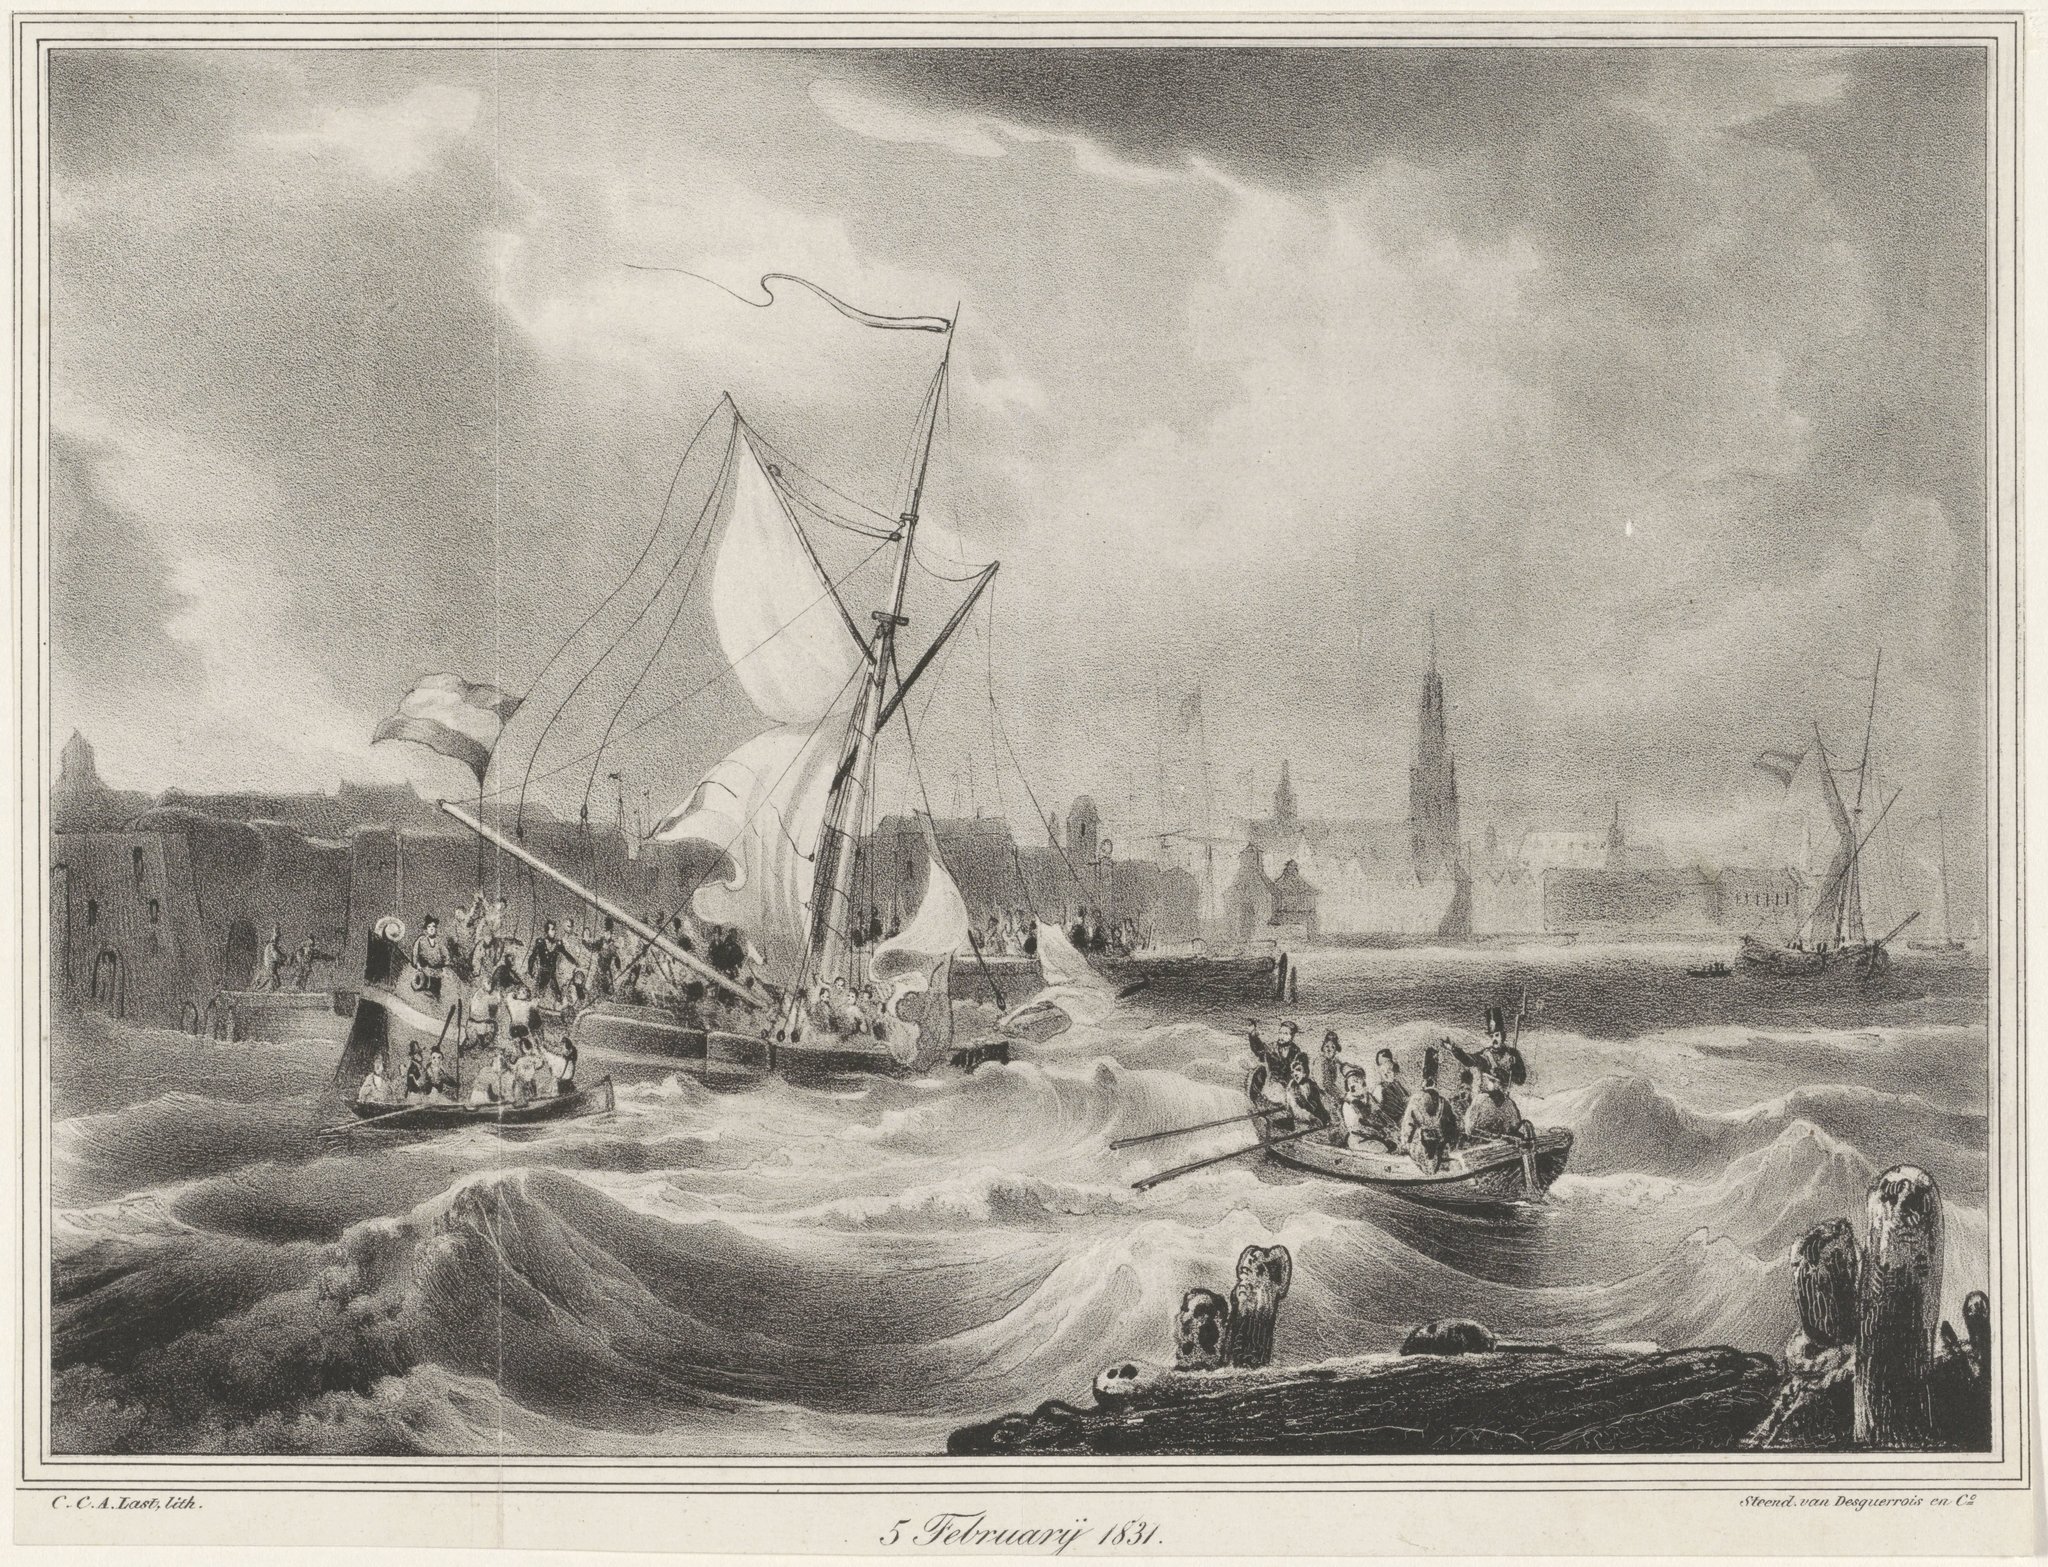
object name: print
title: Overrompelen van de boot van Jan van Speyk, 1831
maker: carel christiaan antony last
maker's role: print maker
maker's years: 1808-1876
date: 1837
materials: paper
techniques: lithograph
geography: netherlands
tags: amsterdam, antwerp, jan van speyk, navy (+ sailing-ships)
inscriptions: collector's mark: Lugt 2228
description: Gebruikt als illustratie in: Nederlandsch museum : geschied- en letterkundige merkwaardigheden, natuurbeschrijvingen, aardrijkskundige bijzonderheden, historische en romantische verhalen : bijeenverzameld uit de pennevruchten van verschillende bekende en anonyme oorspronkelijke schrijvers, alsmede van geleerde en kundige vertalers van de beste stukken uit buitenlandsche periodieken en andere werken. Jaargang 2 (1937), Amsterdam : L. van der Vink. Verkleinde kopie naar de prent van G. Craeyvanger (FMH 6604).